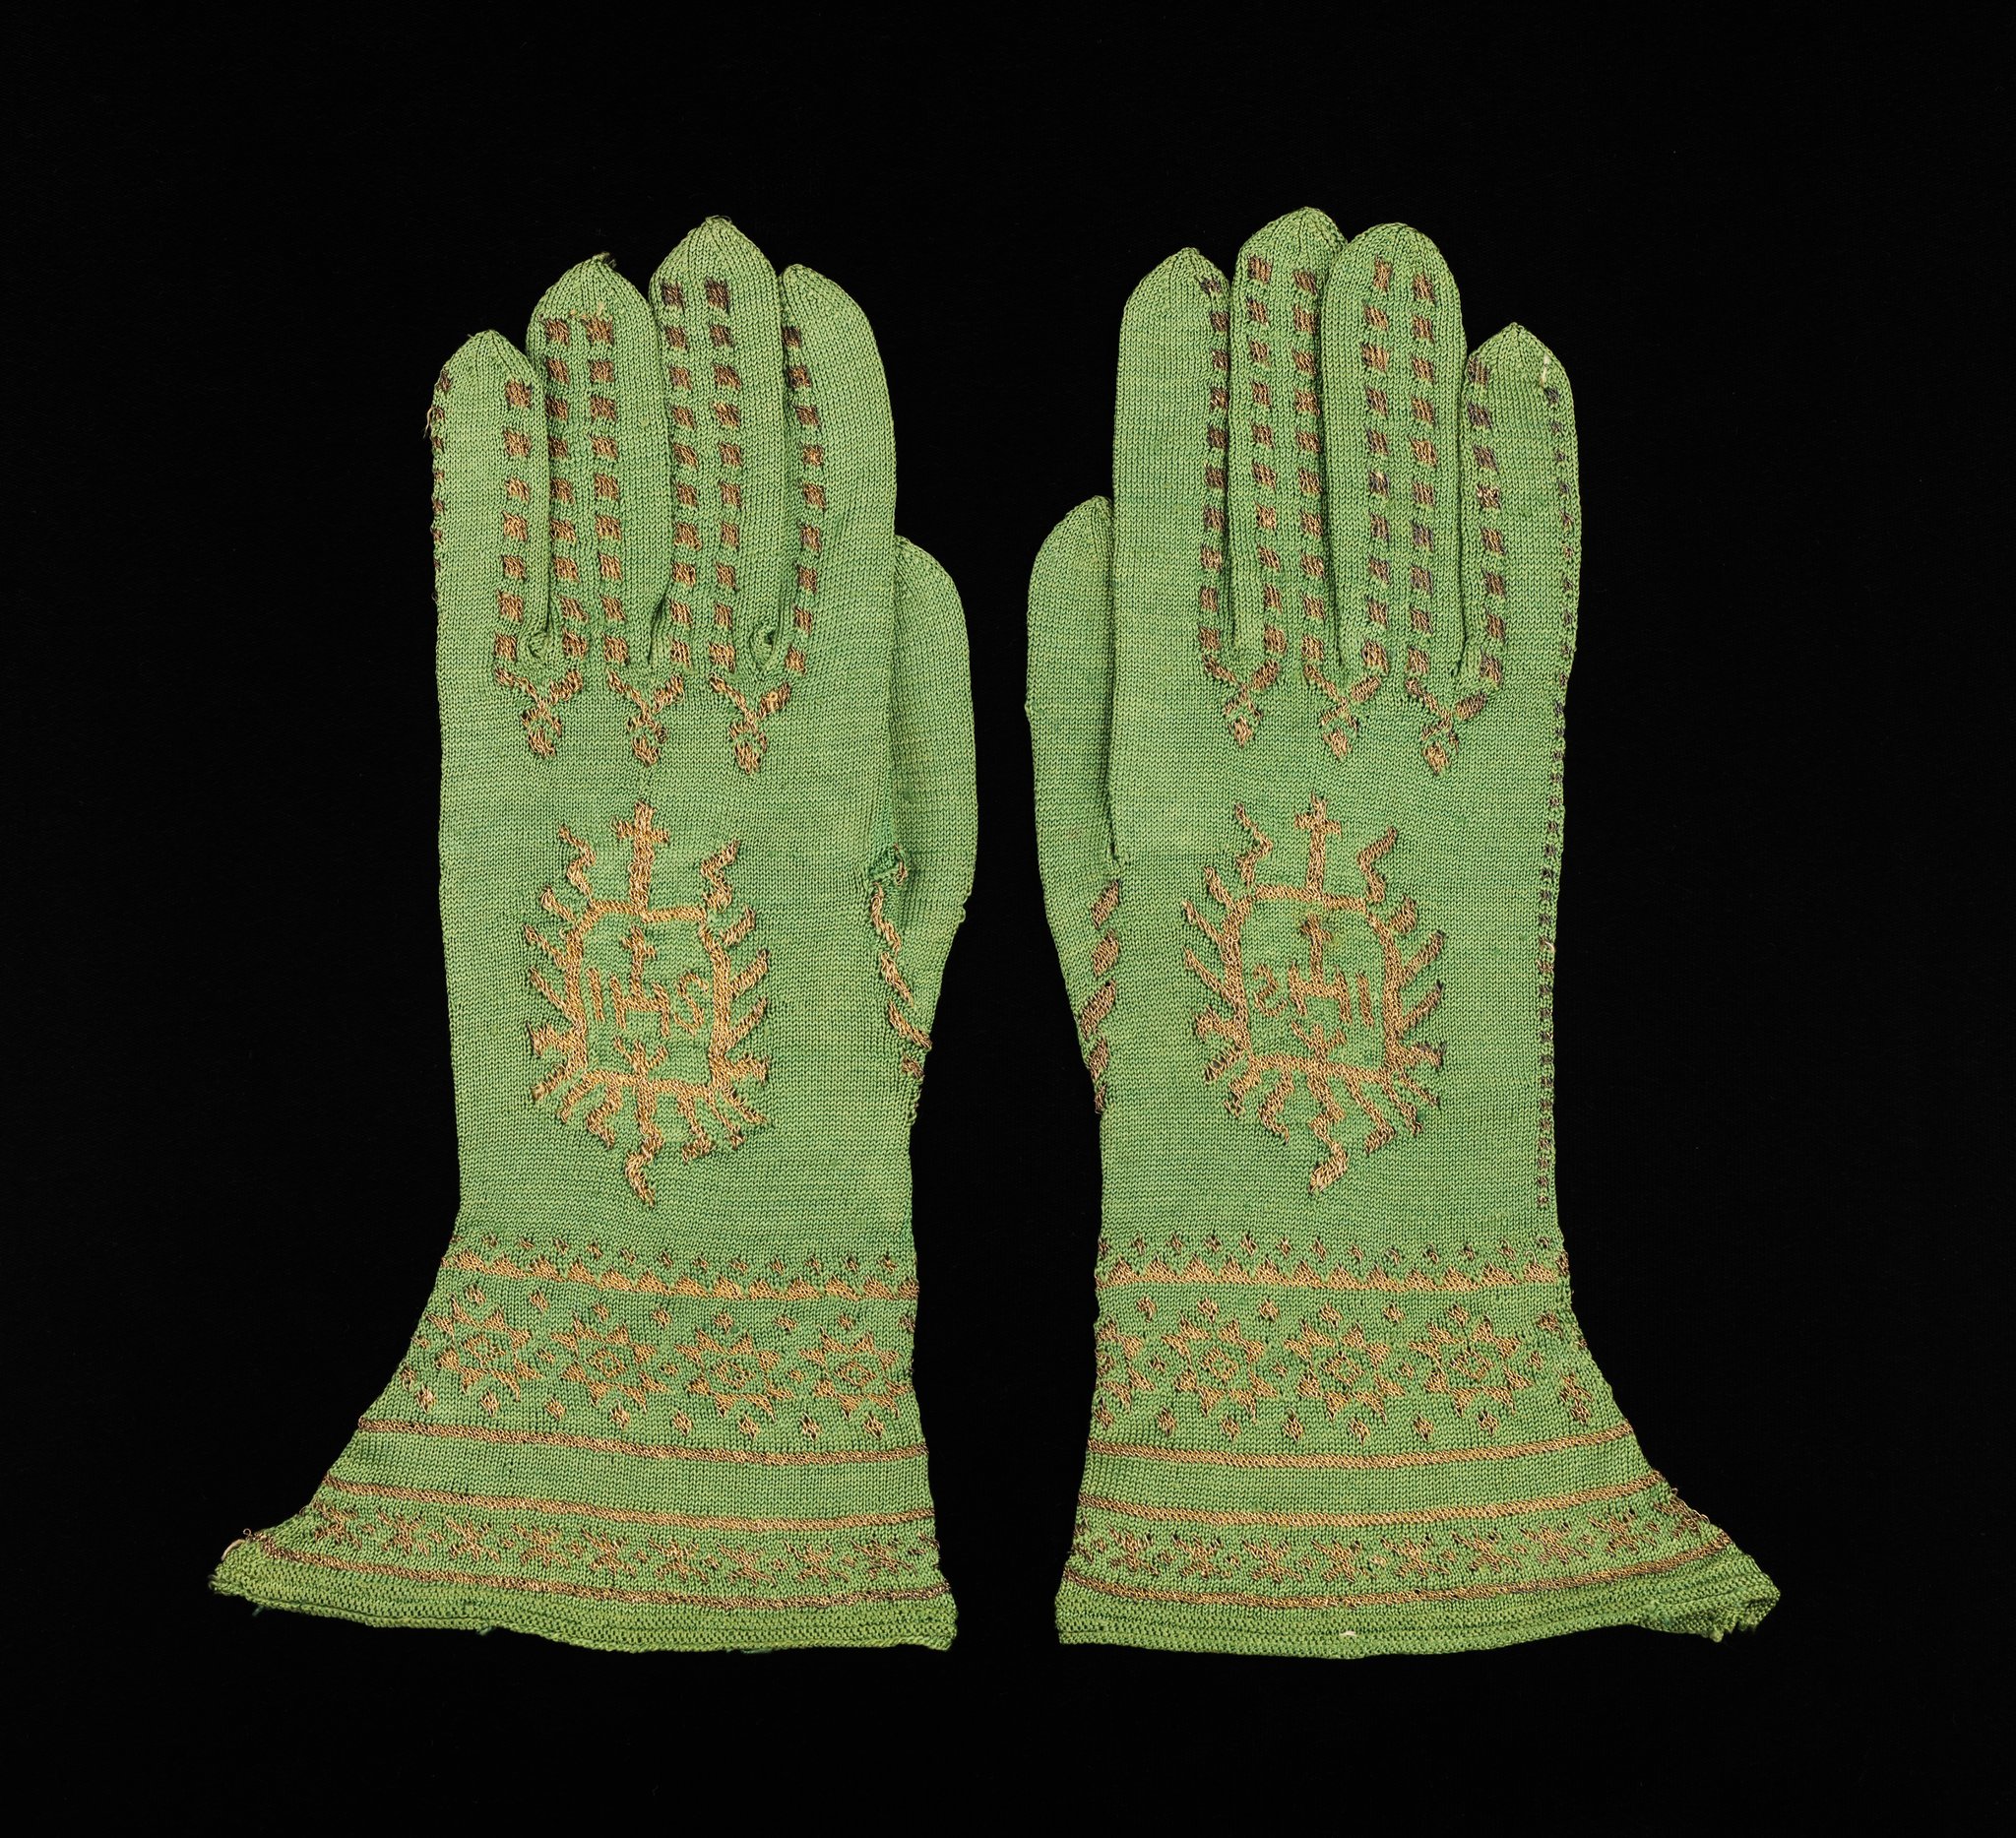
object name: glove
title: Bishop's Gloves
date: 1676-1700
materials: metal, silk